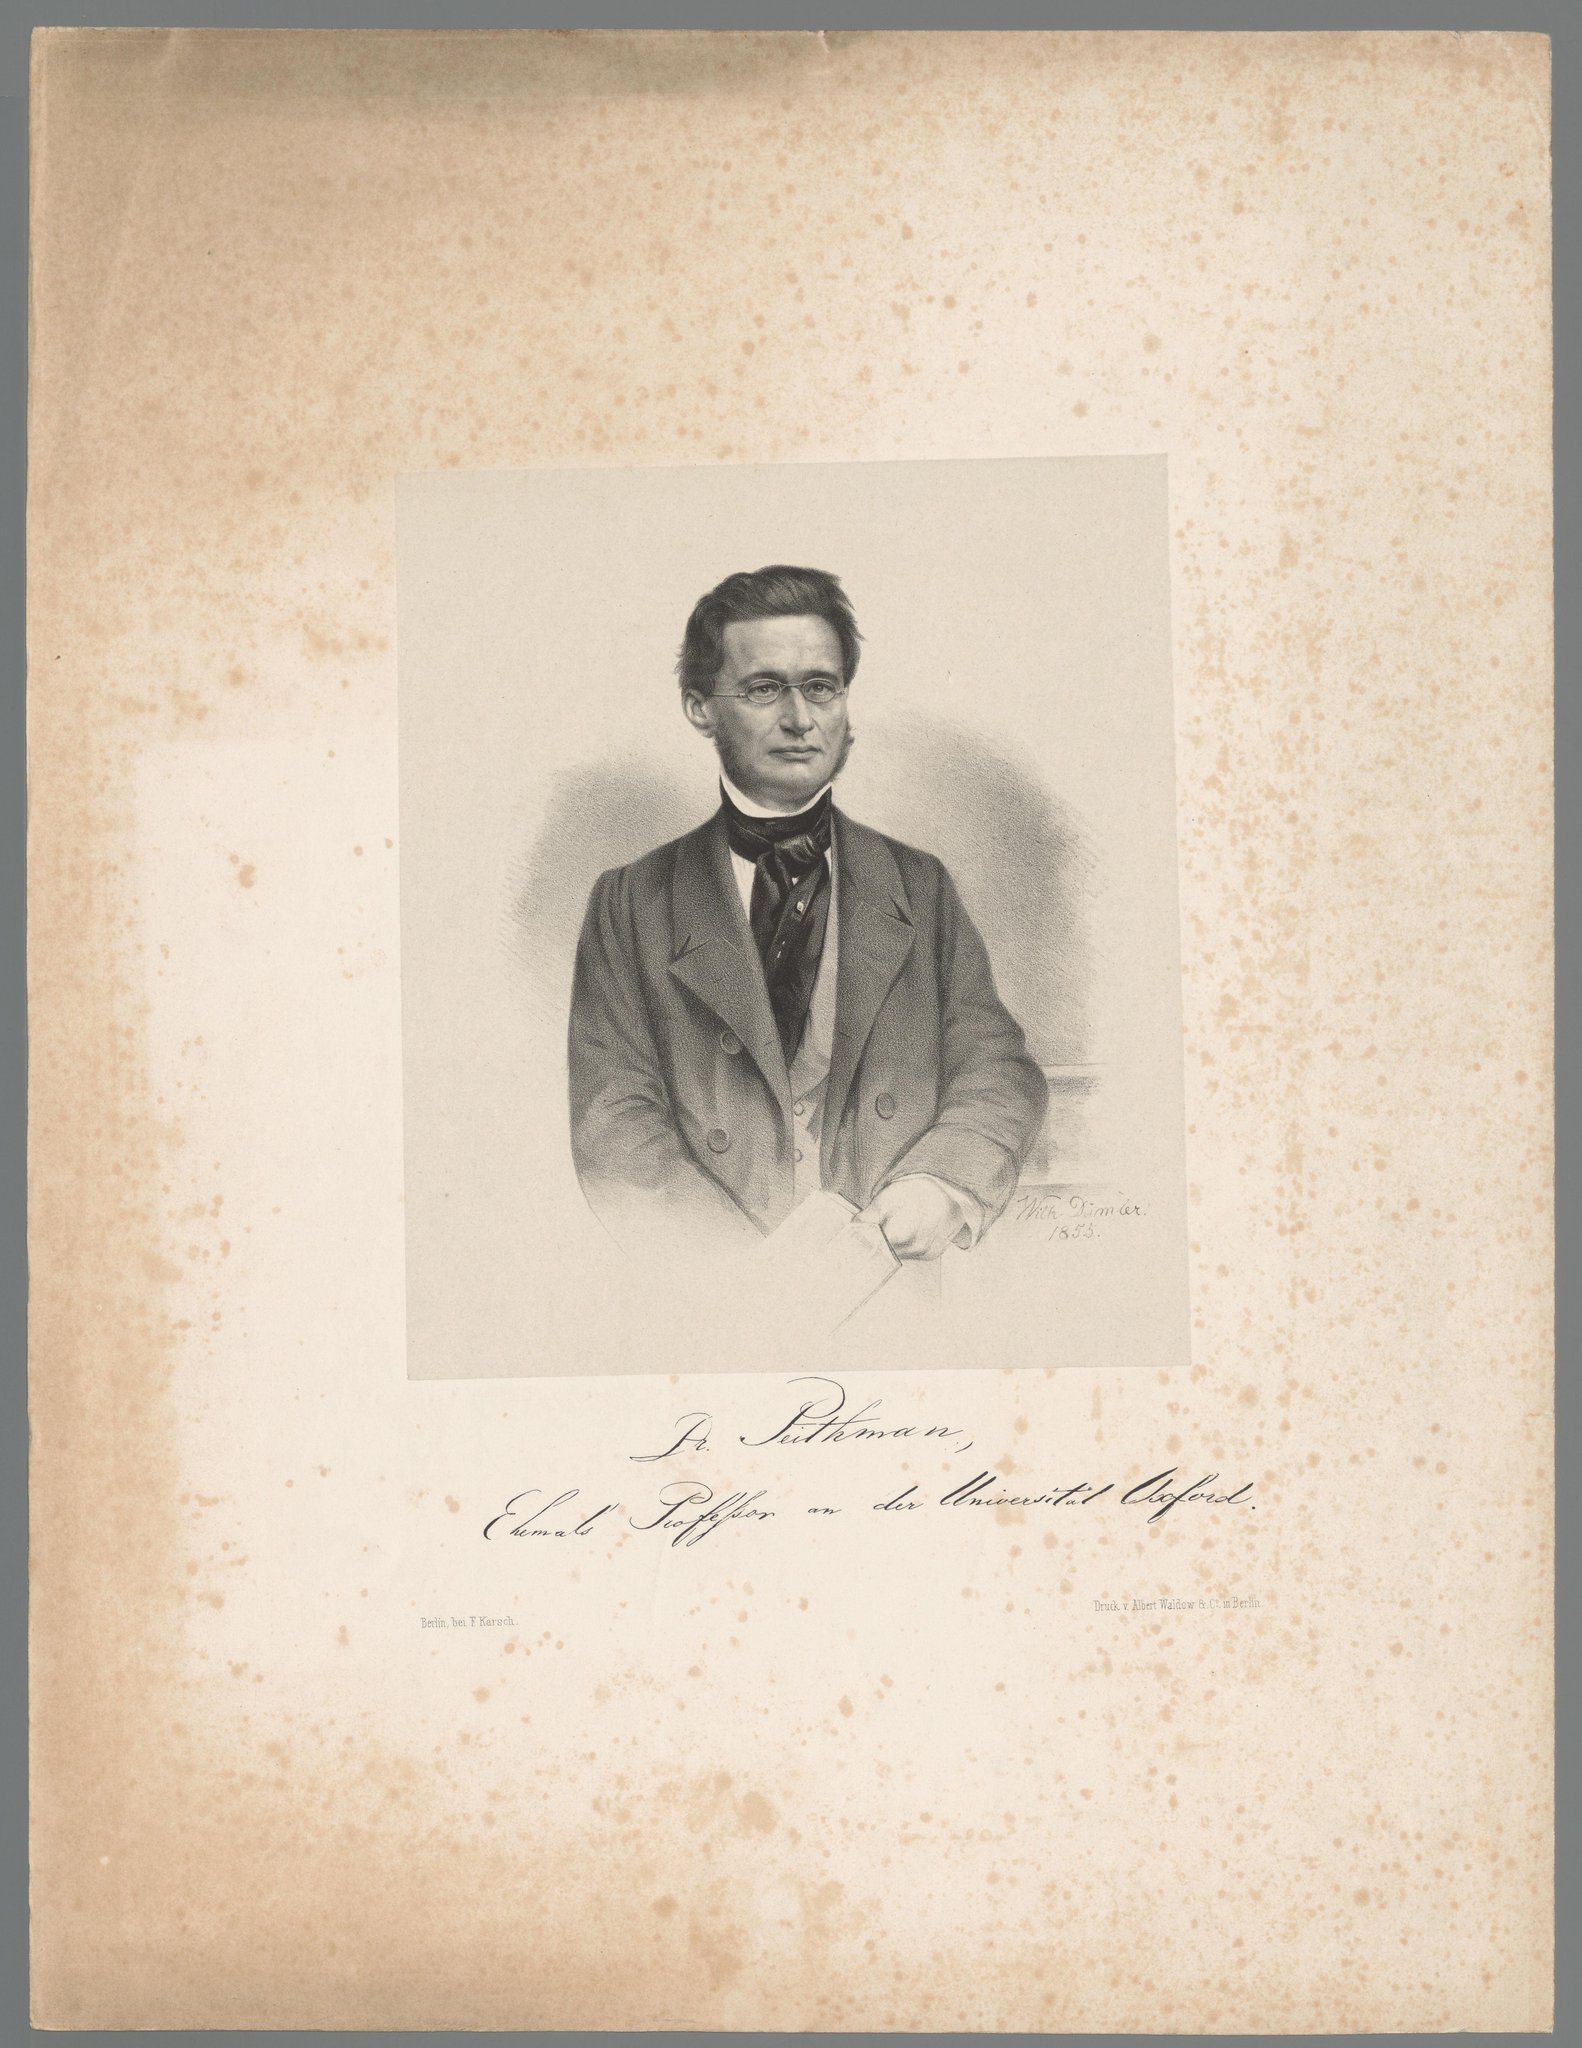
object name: print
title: Portret van een onbekende man, mogelijk Peithman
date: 1855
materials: paper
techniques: lithograph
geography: berlin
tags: eyeglasses, spectacles, adult man, historical persons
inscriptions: collector's mark: Lugt 2228